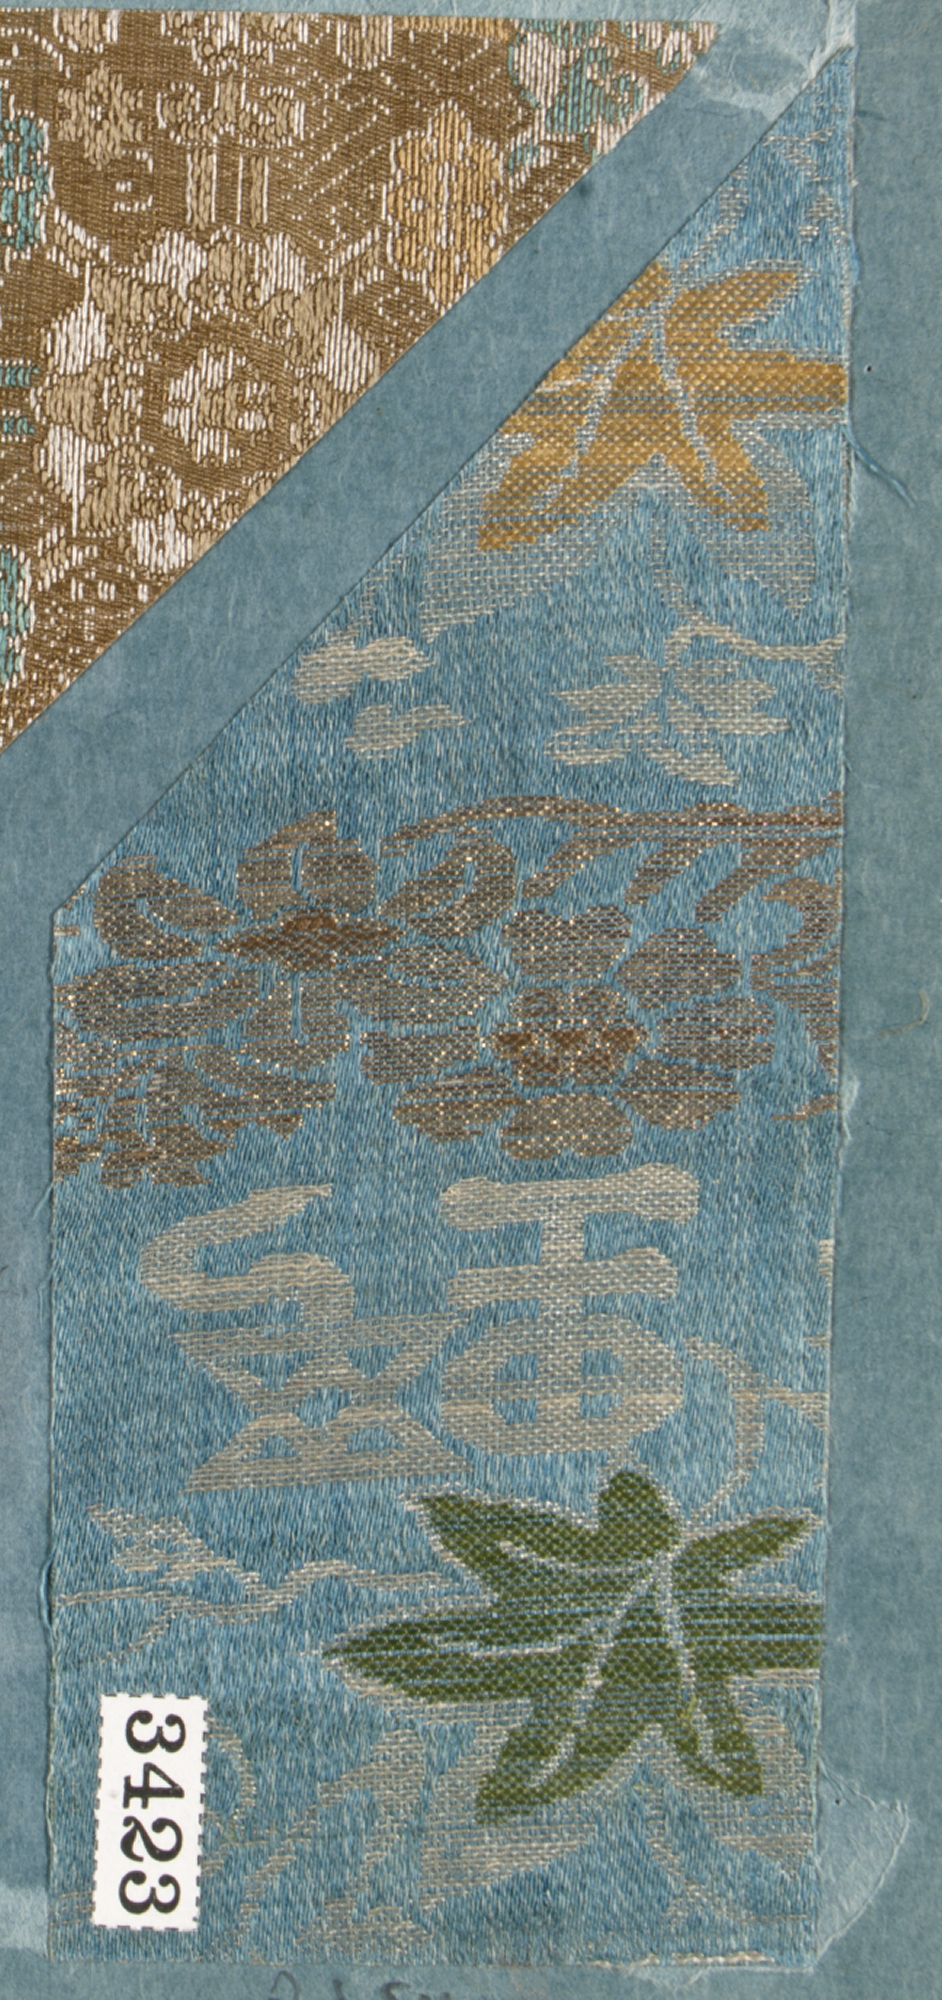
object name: textile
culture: japanese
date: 1801-1900